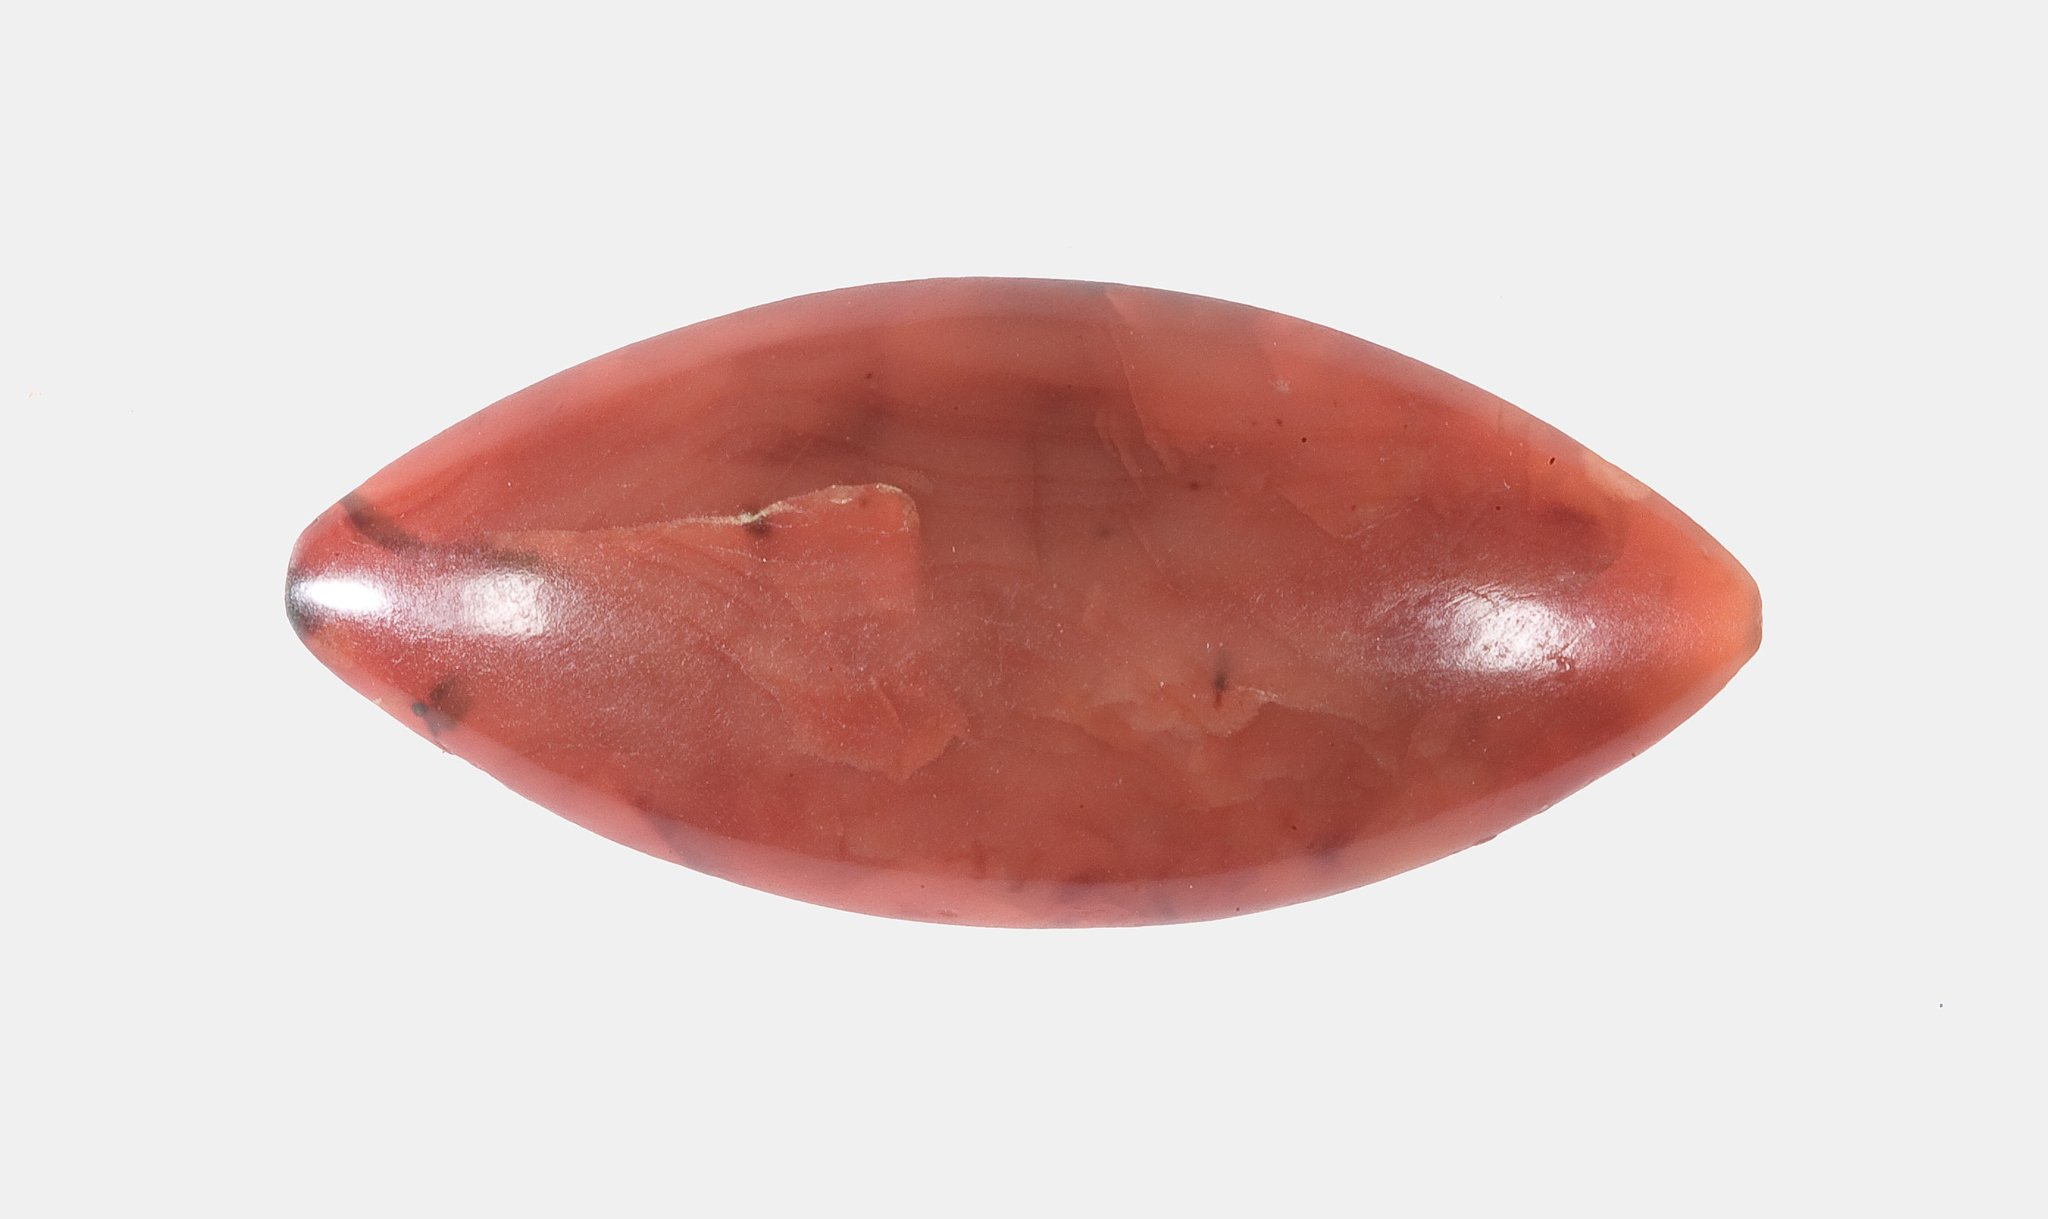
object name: bead, sweret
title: Sweret bead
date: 1981-1950 BCE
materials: gemstone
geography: egypt